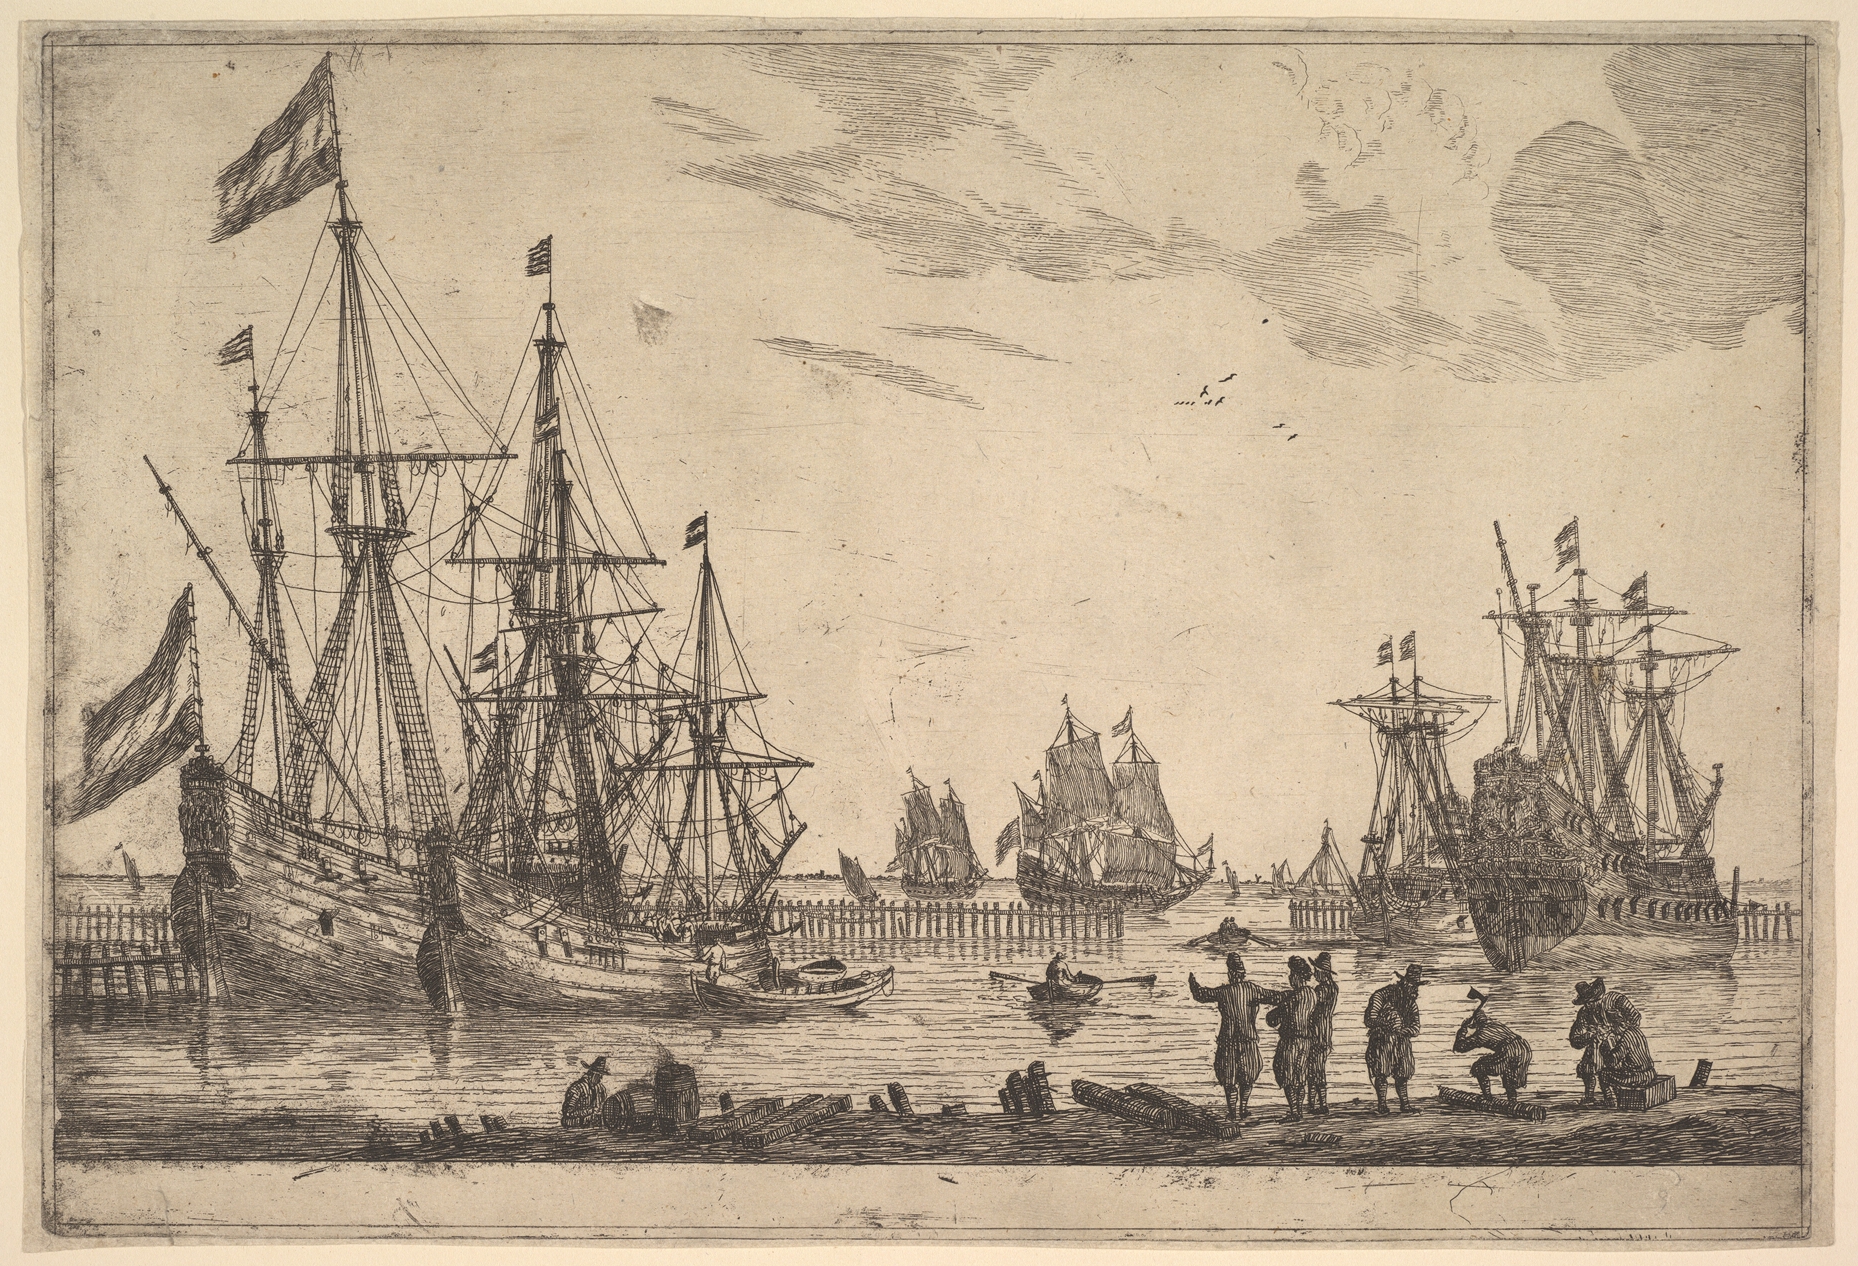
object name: print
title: Four Sailing Vessels near a Breakwater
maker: reinier nooms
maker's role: artist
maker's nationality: dutch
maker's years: 1623-1664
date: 1601-1700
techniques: etching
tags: men,ships